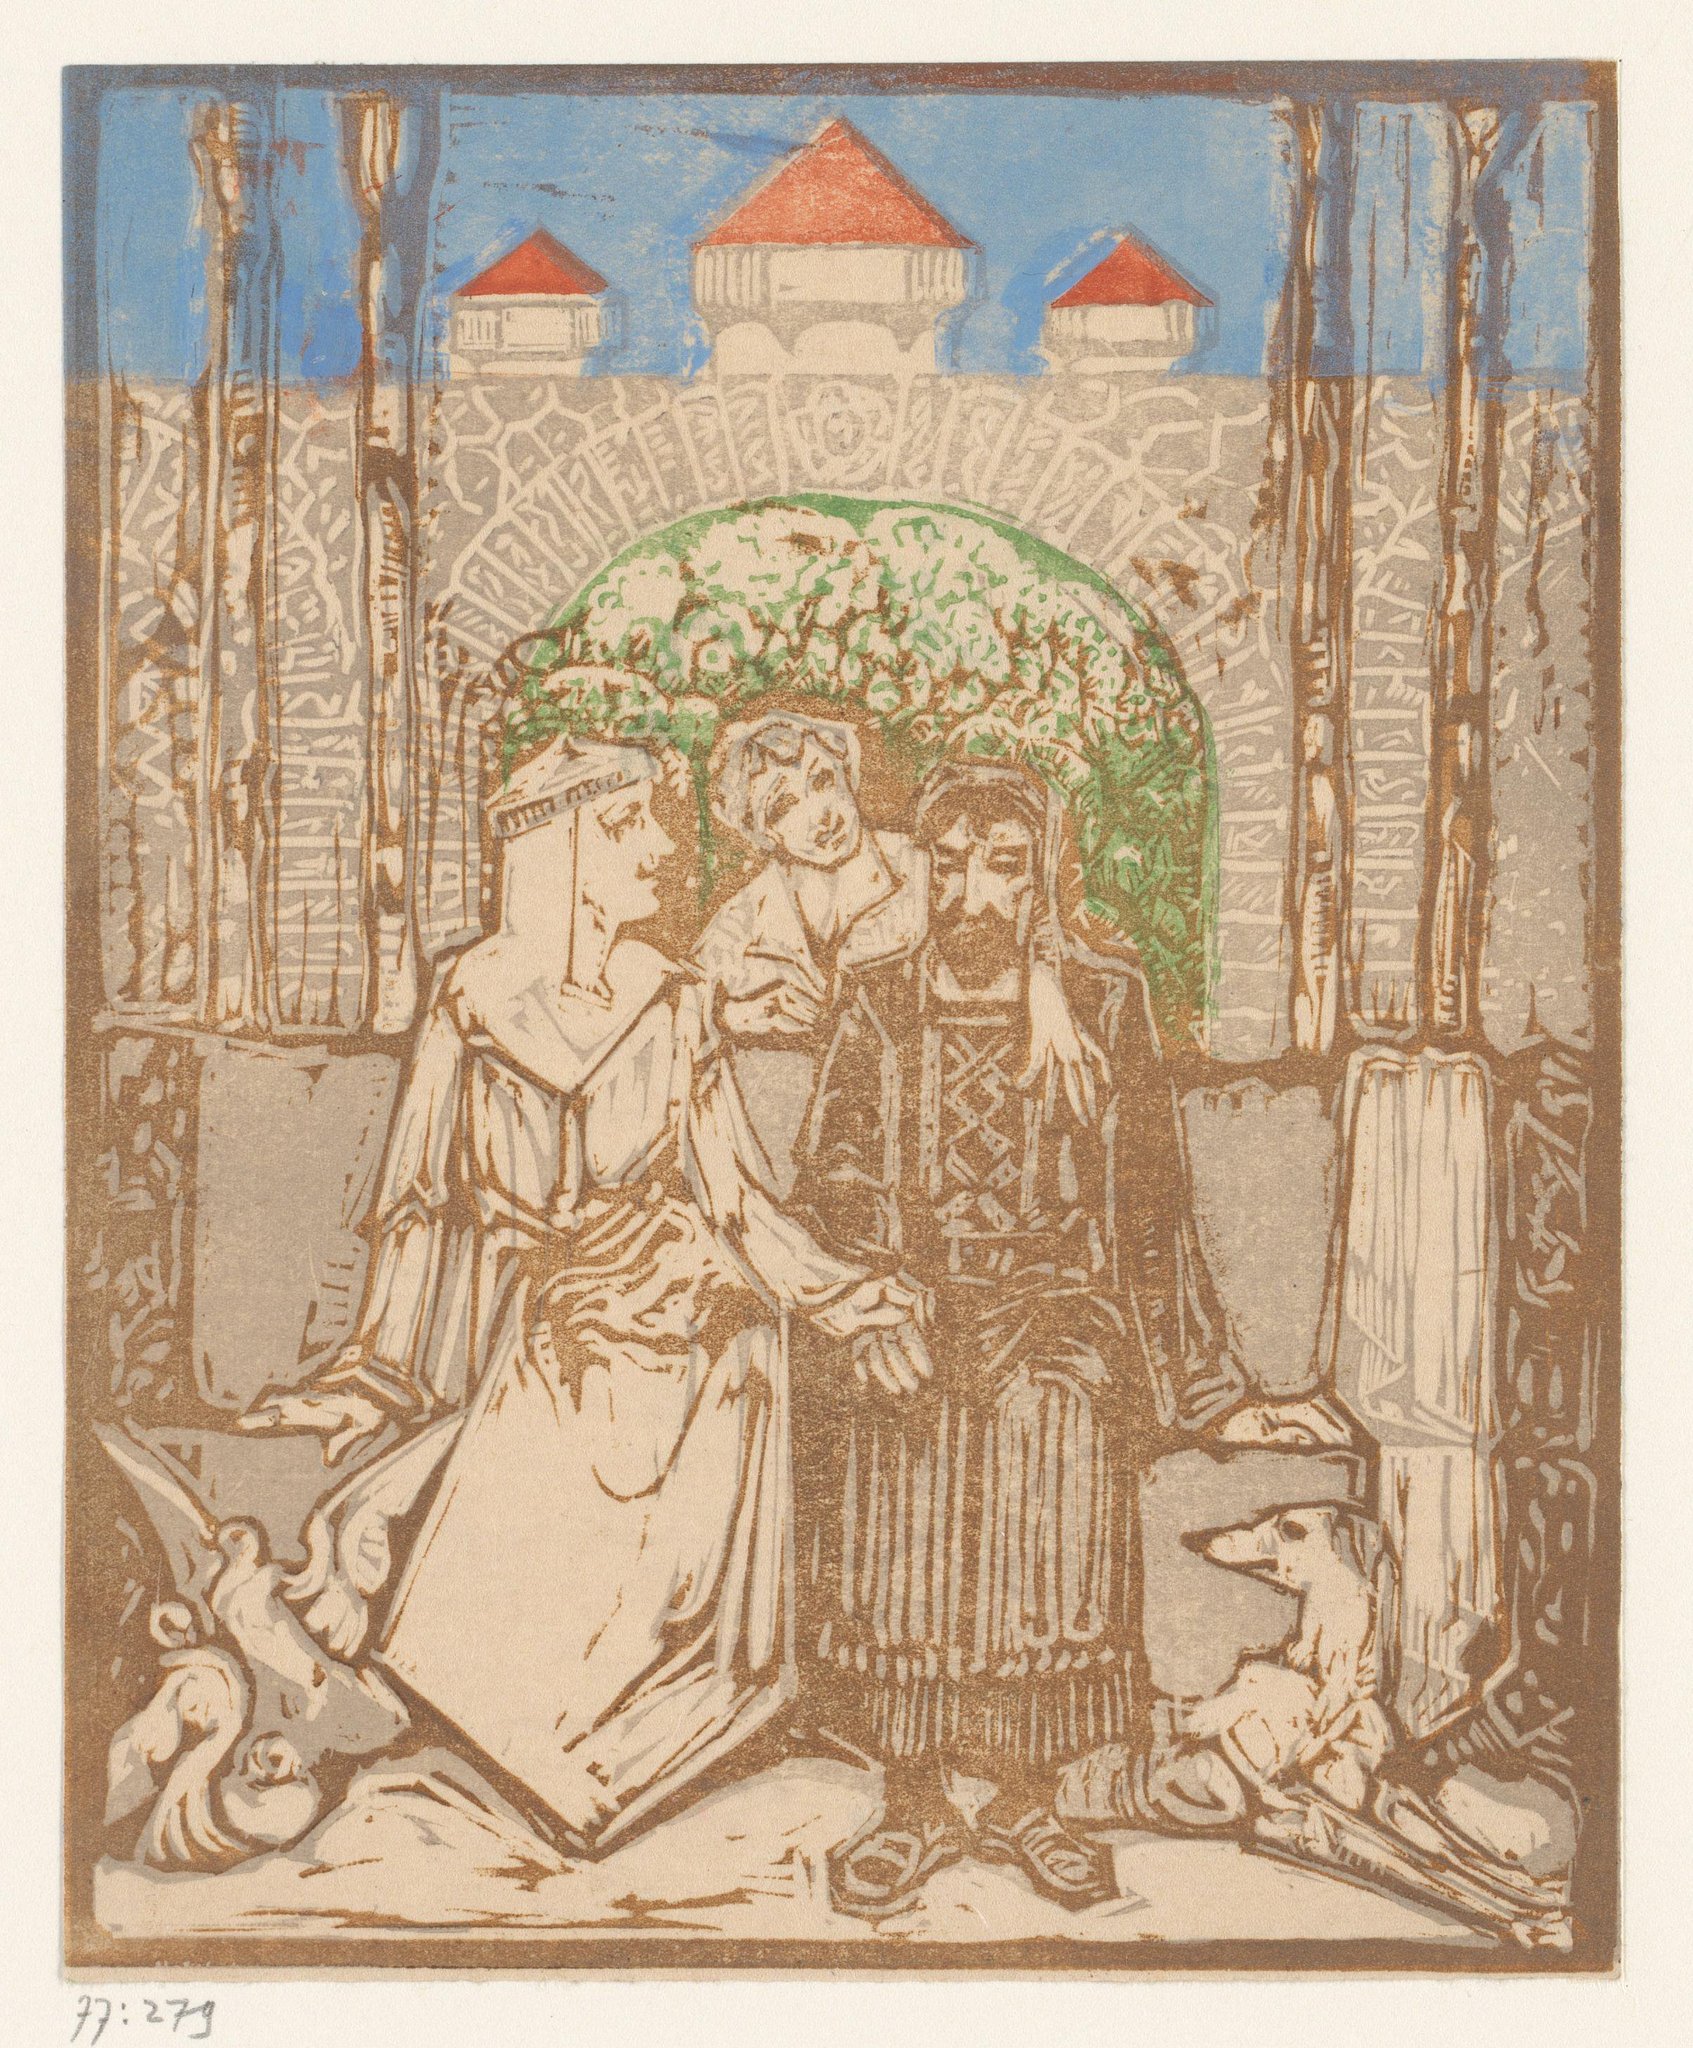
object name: print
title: Zittend paar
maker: bernard willem wierink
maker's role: draughtsman, print maker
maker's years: 1856-1939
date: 1938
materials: paper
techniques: relief print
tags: other birds: dove, couple of lovers, dog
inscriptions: collector's mark: Lugt 2228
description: Illustratie voor een uitgave van een onbekend toneelstuk. Deze prent is waarschijnlijk een plaatsnede, ook al wordt in de literatuur veelal gesproken over een houtsnede. Voor zover Wierink zijn prenten in hoogdruk zelf heeft omschreven, heeft hij altijd de term 'plaatsnede' gebruikt.